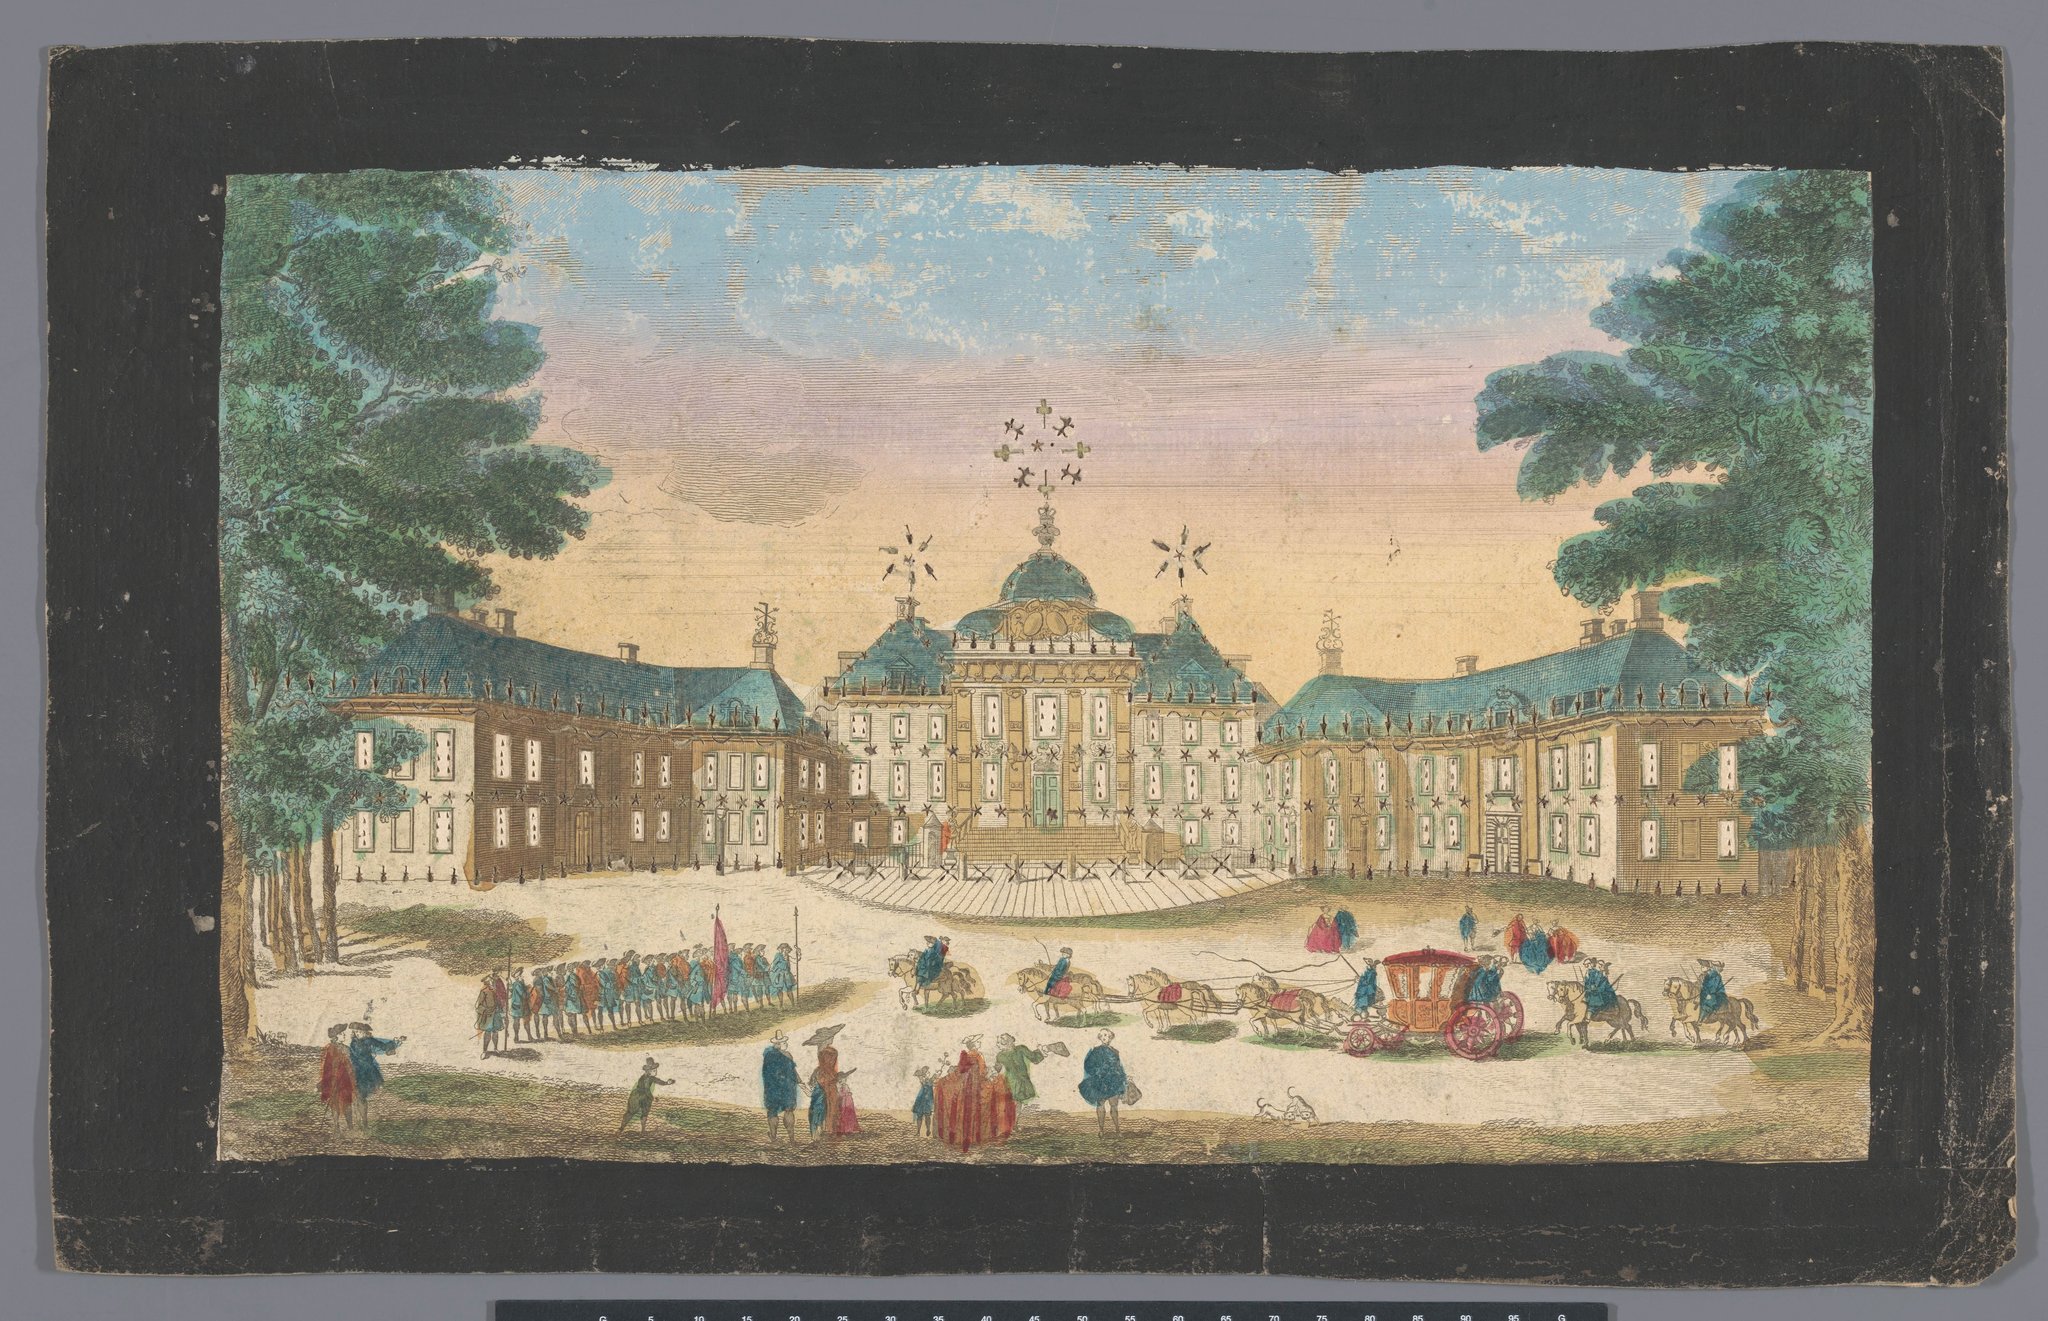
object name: opticaprent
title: Gezicht op de voorzijde van het Paleis Huis ten Bosch te Den Haag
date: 1700-1799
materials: cardboard, paint, paper, watercolor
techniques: brush, cutting, etching, perforating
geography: france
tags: palace, four-wheeled vehicle drawn by more than three animals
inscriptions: collector's mark: Lugt 2233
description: Rechts rijdt een koets getrokken door zes paarden.